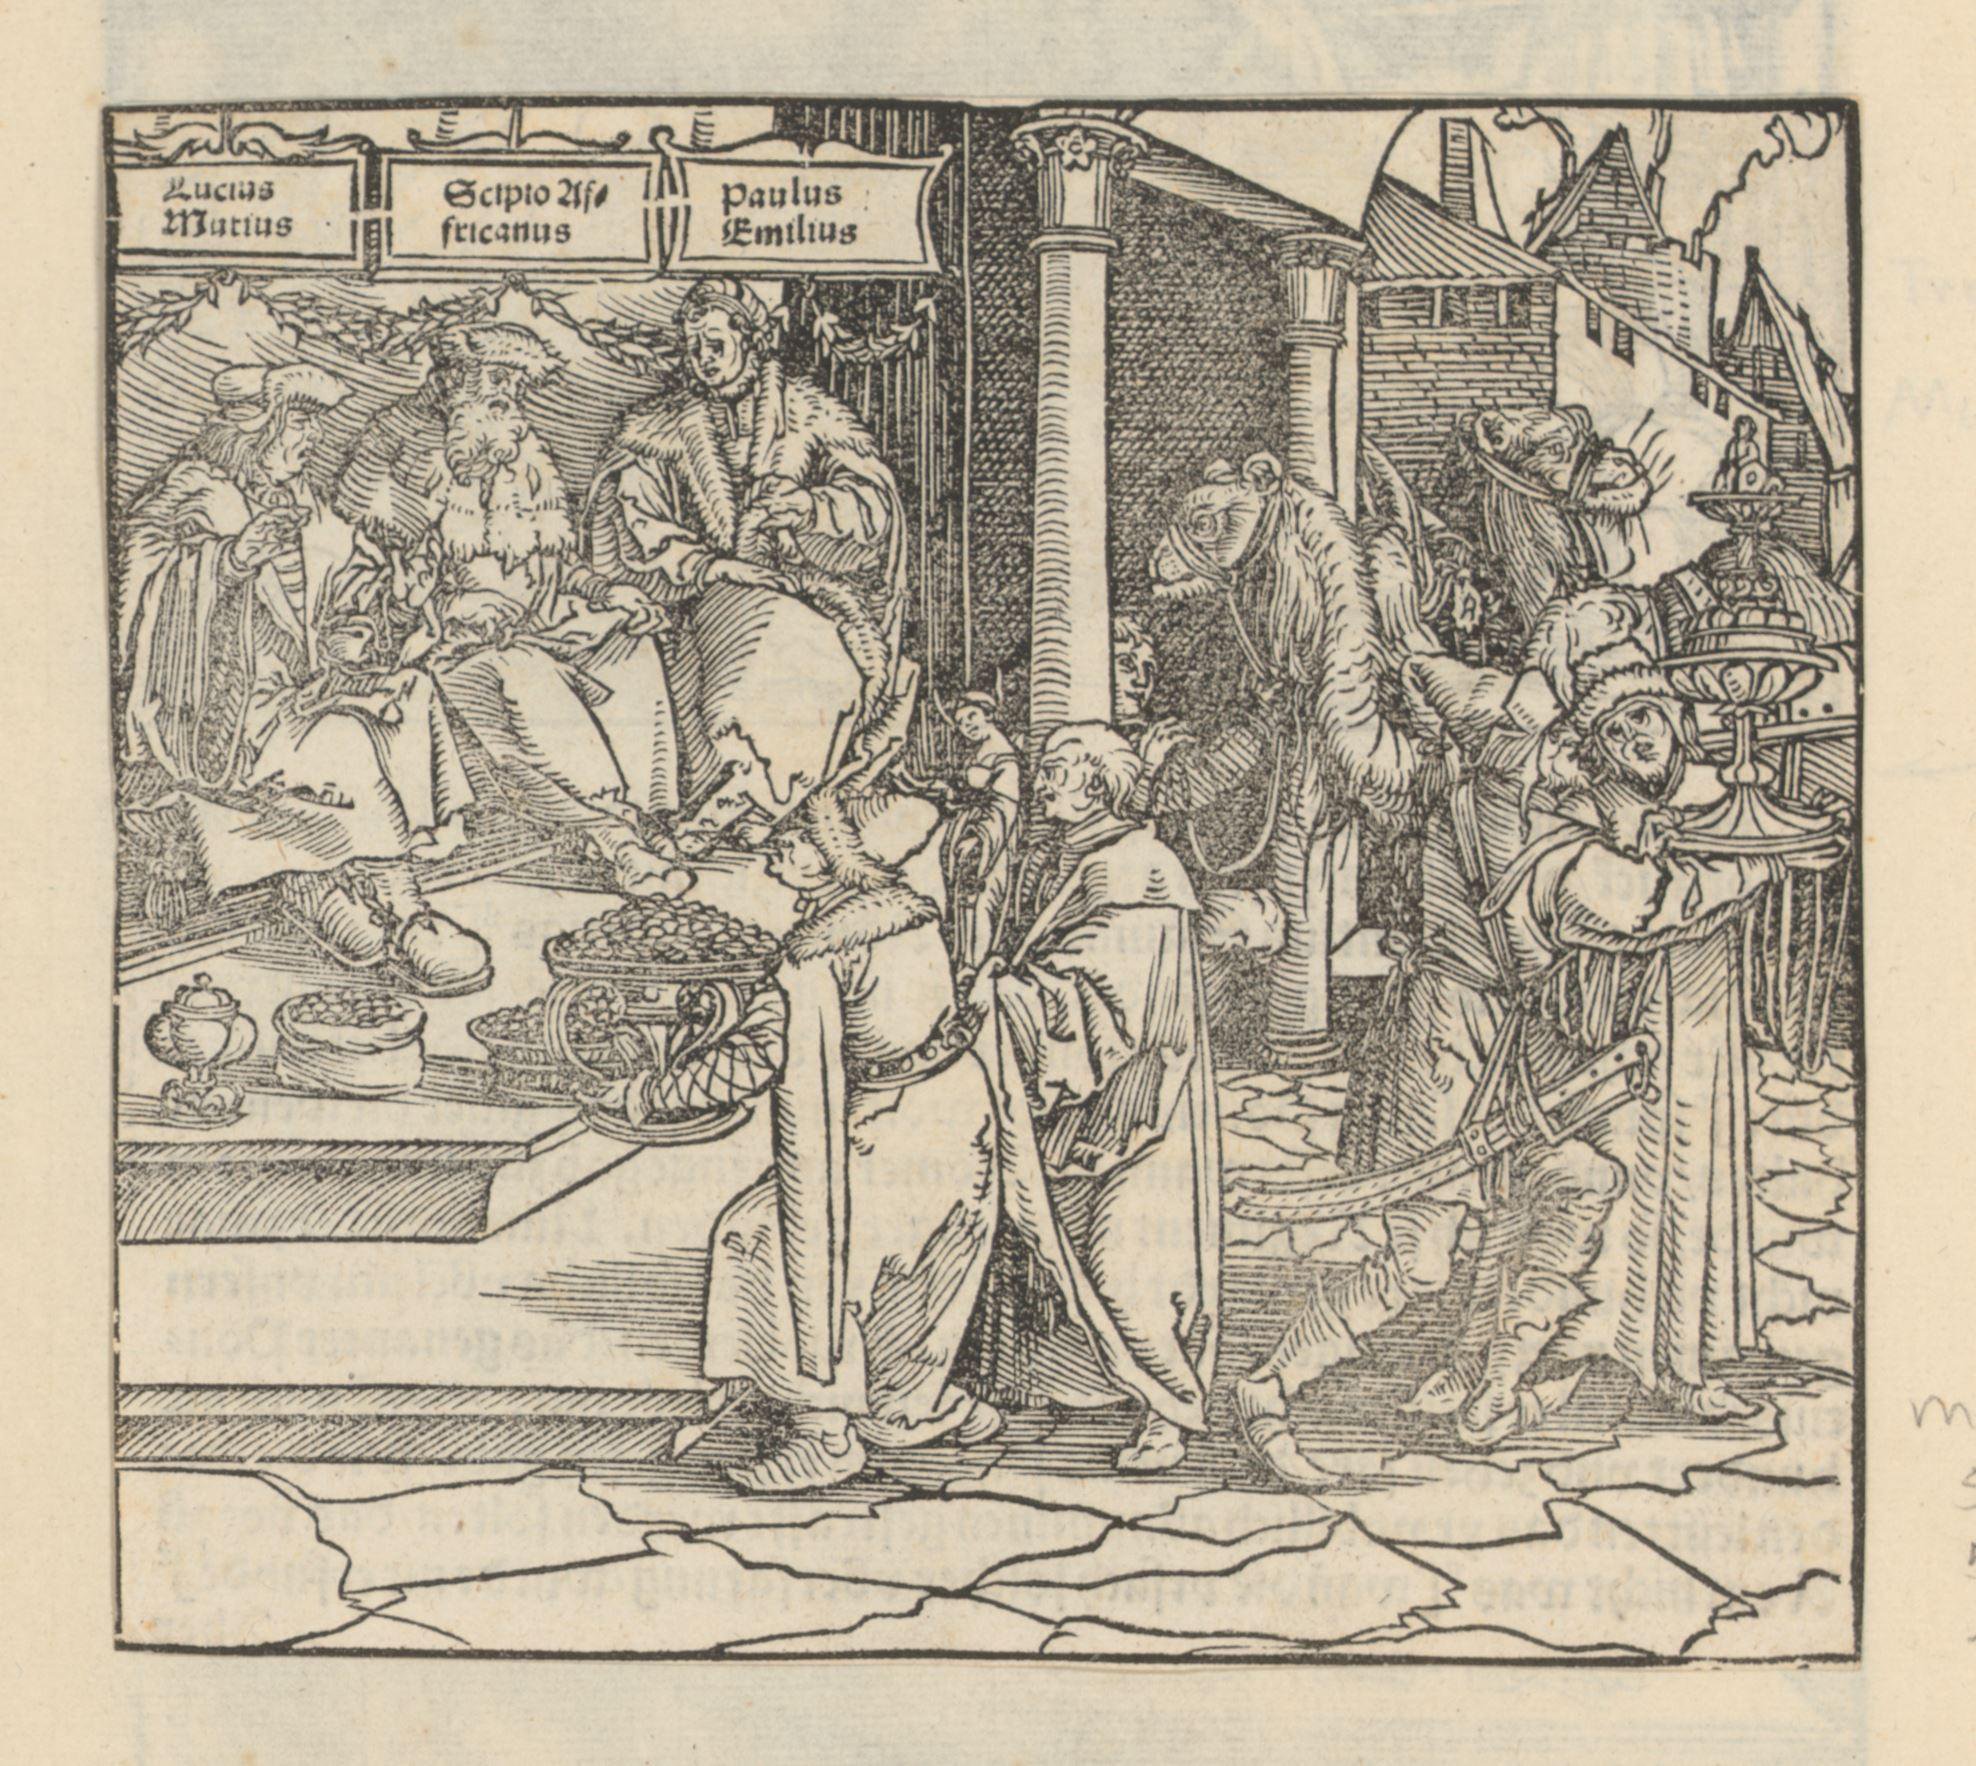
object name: print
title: Lucius Mutius, Scipio Africanus Maior en Lucius Aemilius Paulus I ontvangen kostbaarheden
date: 1514-1531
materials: paper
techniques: letterpress printing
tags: gifts being accepted, (story of) p. cornelius scipio africanus major, (story of) lucius aemilius paul(l)us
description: Deze prent is gebruikt in: Cicero, Marcus Tulius. Officia M.T.C. Ein Buch so Marcus Tullius Cicero der Römer zu seynem (...). [Vertaald uit het Latijn door] Johann von Schwarzenberg. Augsburg: Heinrich Steiner, 1531.